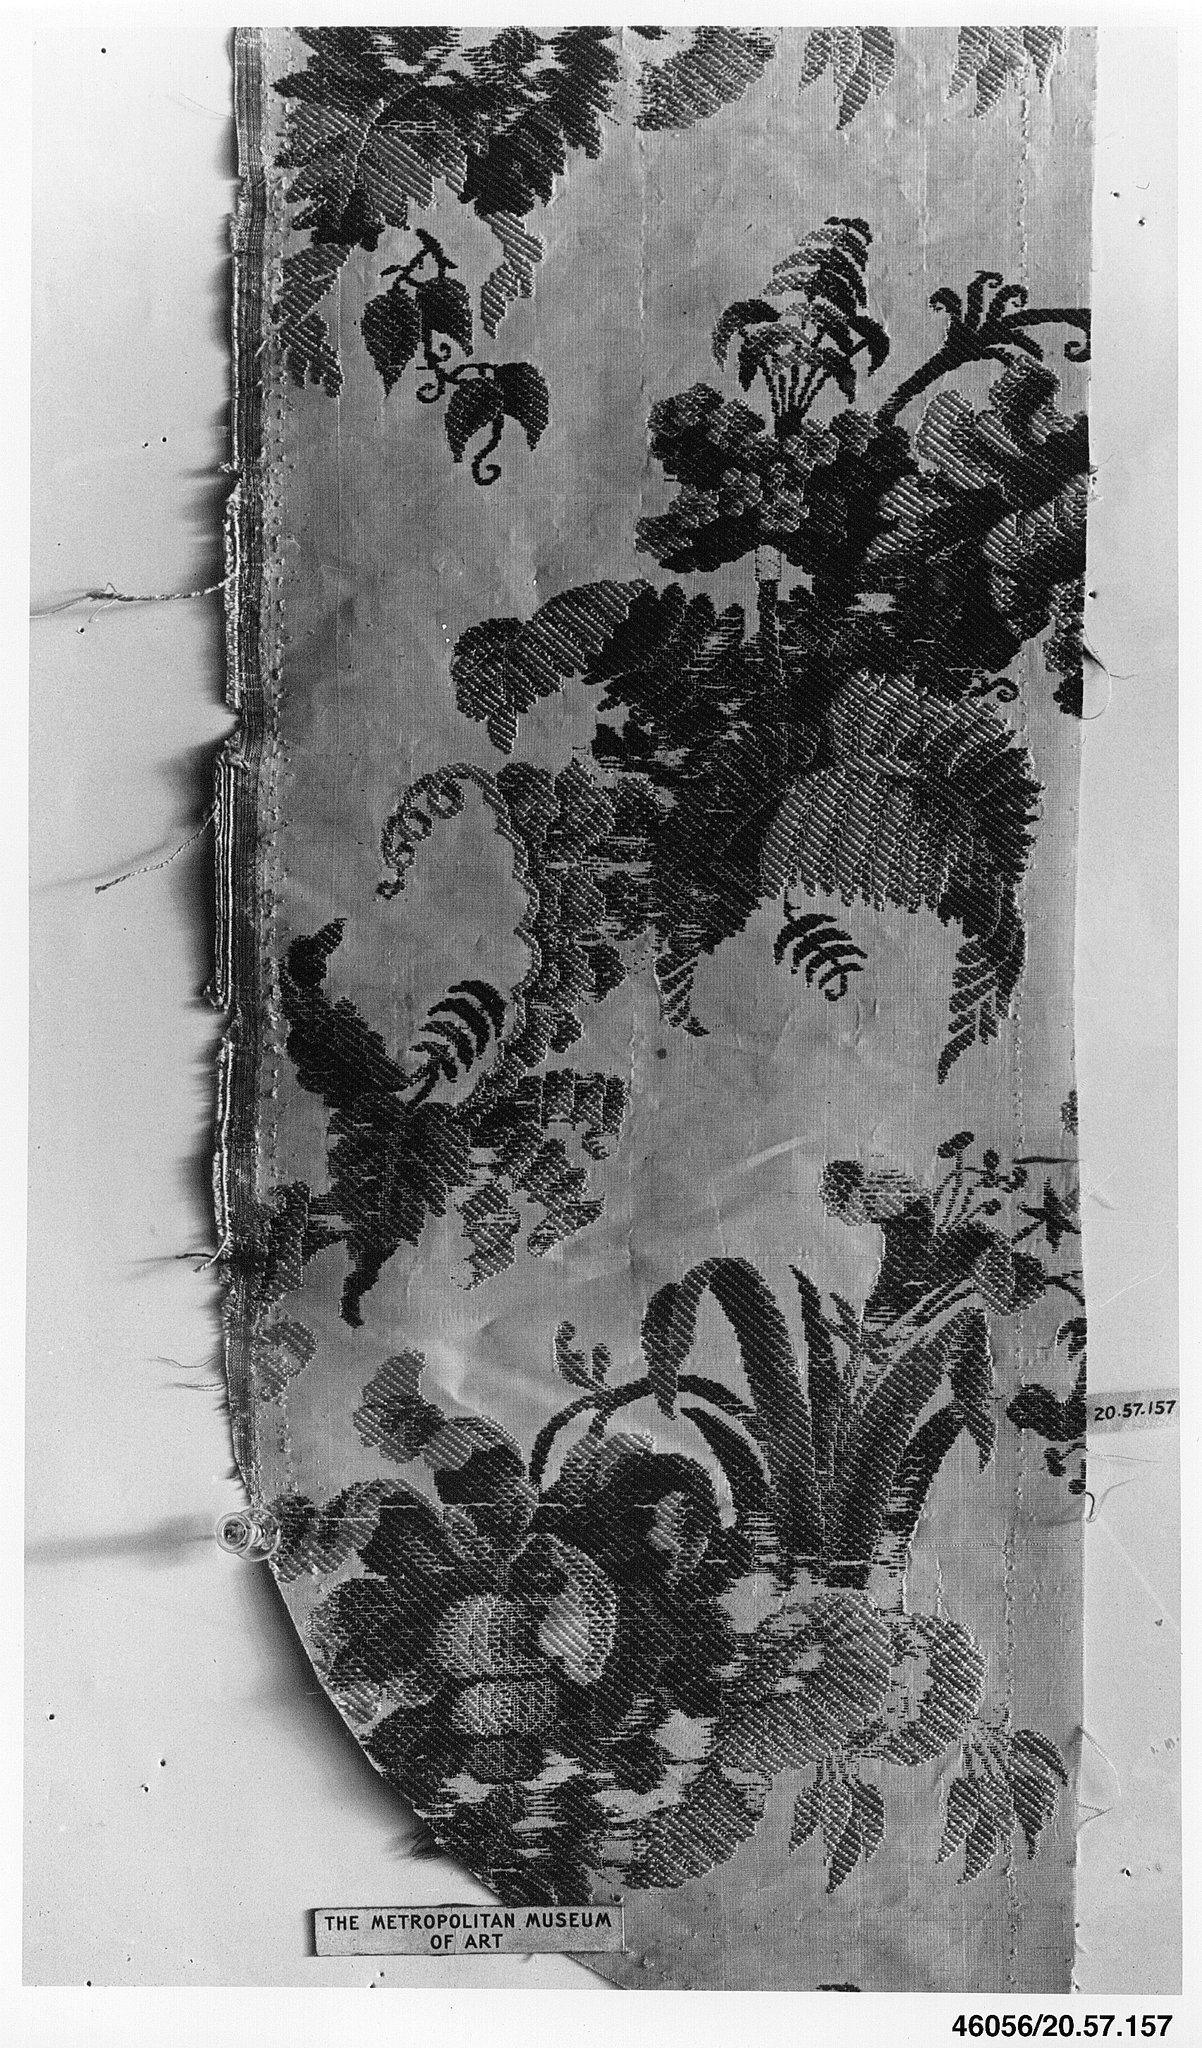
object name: piece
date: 1735-1740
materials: silk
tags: flowers,leaves